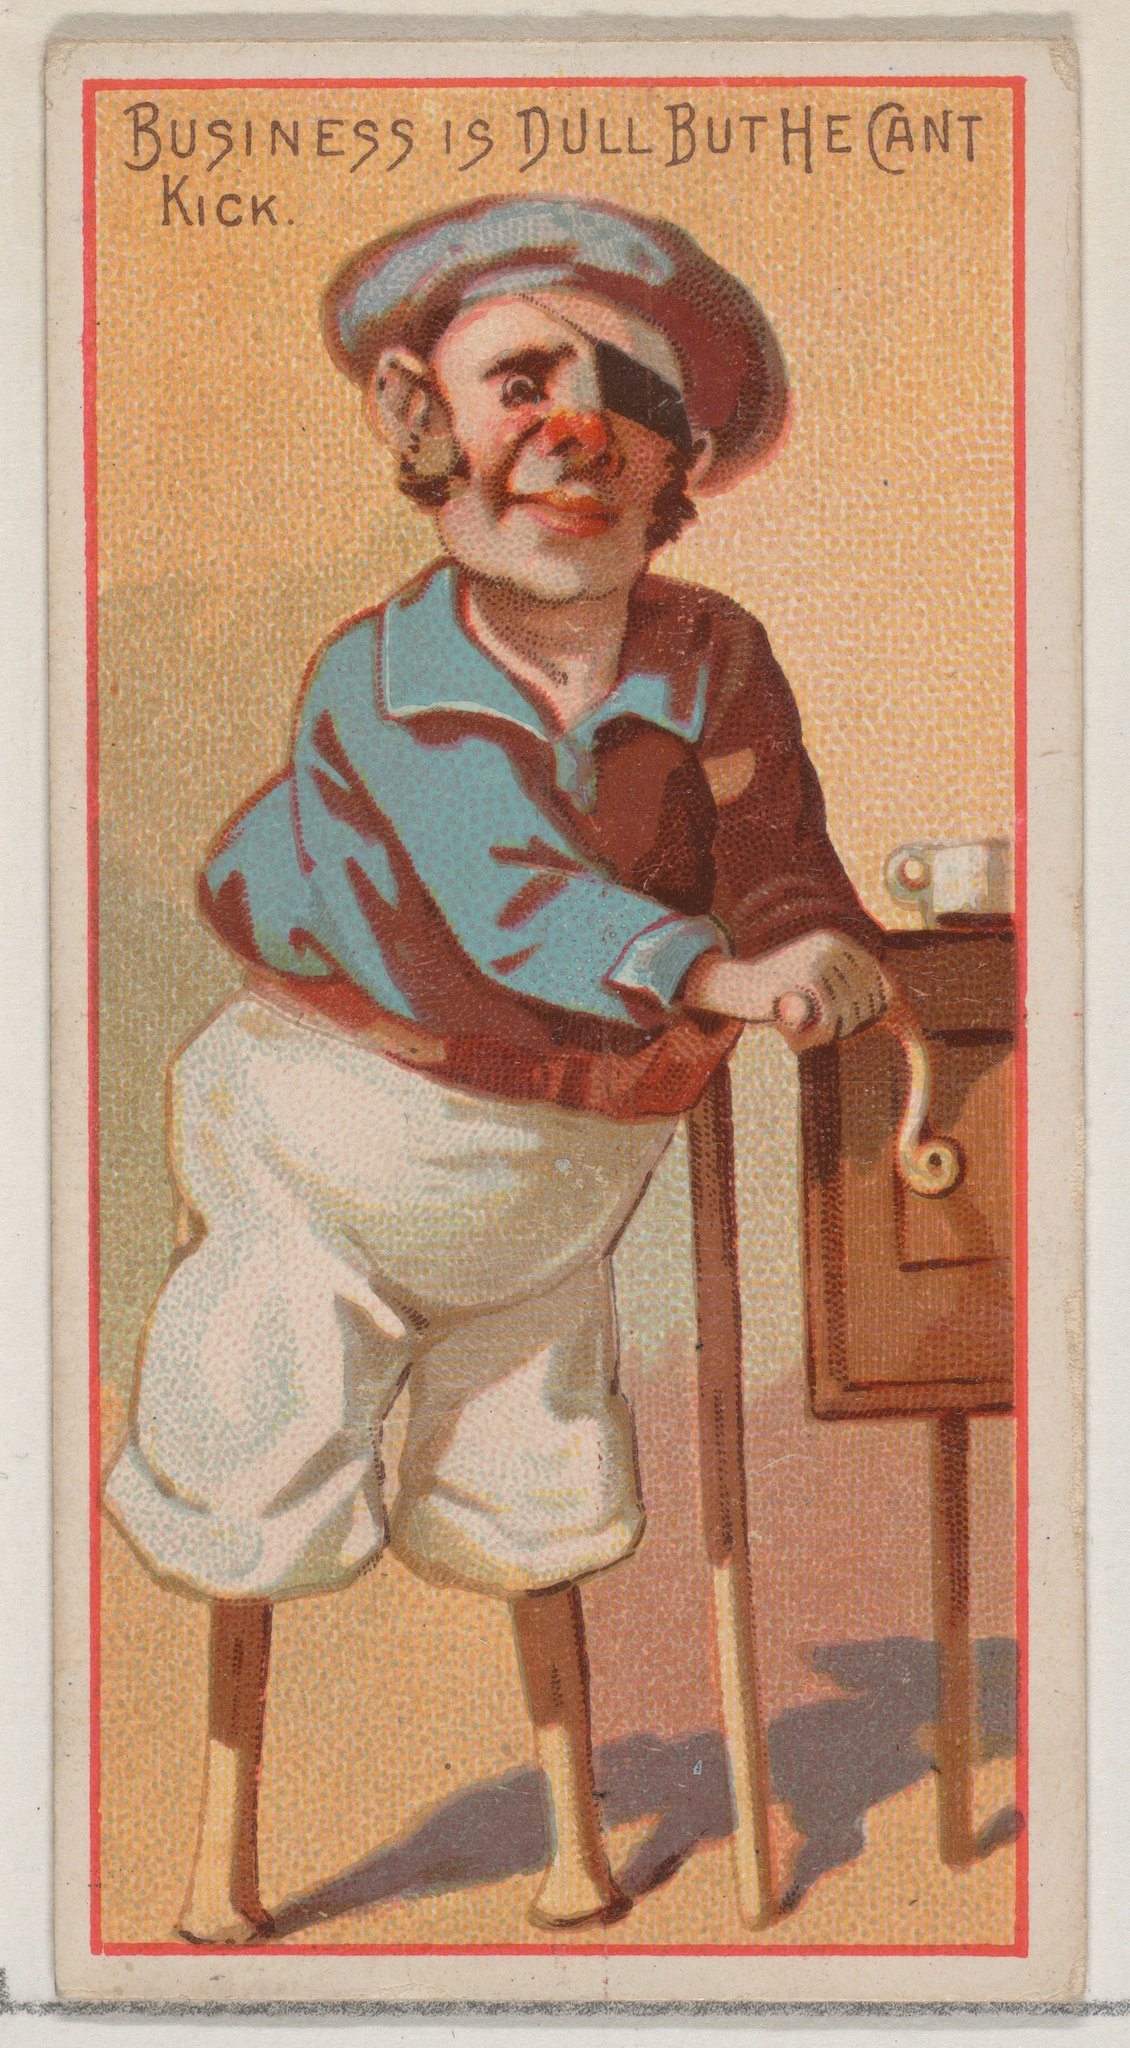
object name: print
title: Business is Dull but He Can't Kick, from the Jokes series (N87) for Duke brand cigarettes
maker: w. duke, sons & co.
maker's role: publisher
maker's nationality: american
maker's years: 1870-1920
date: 1890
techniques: color lithograph